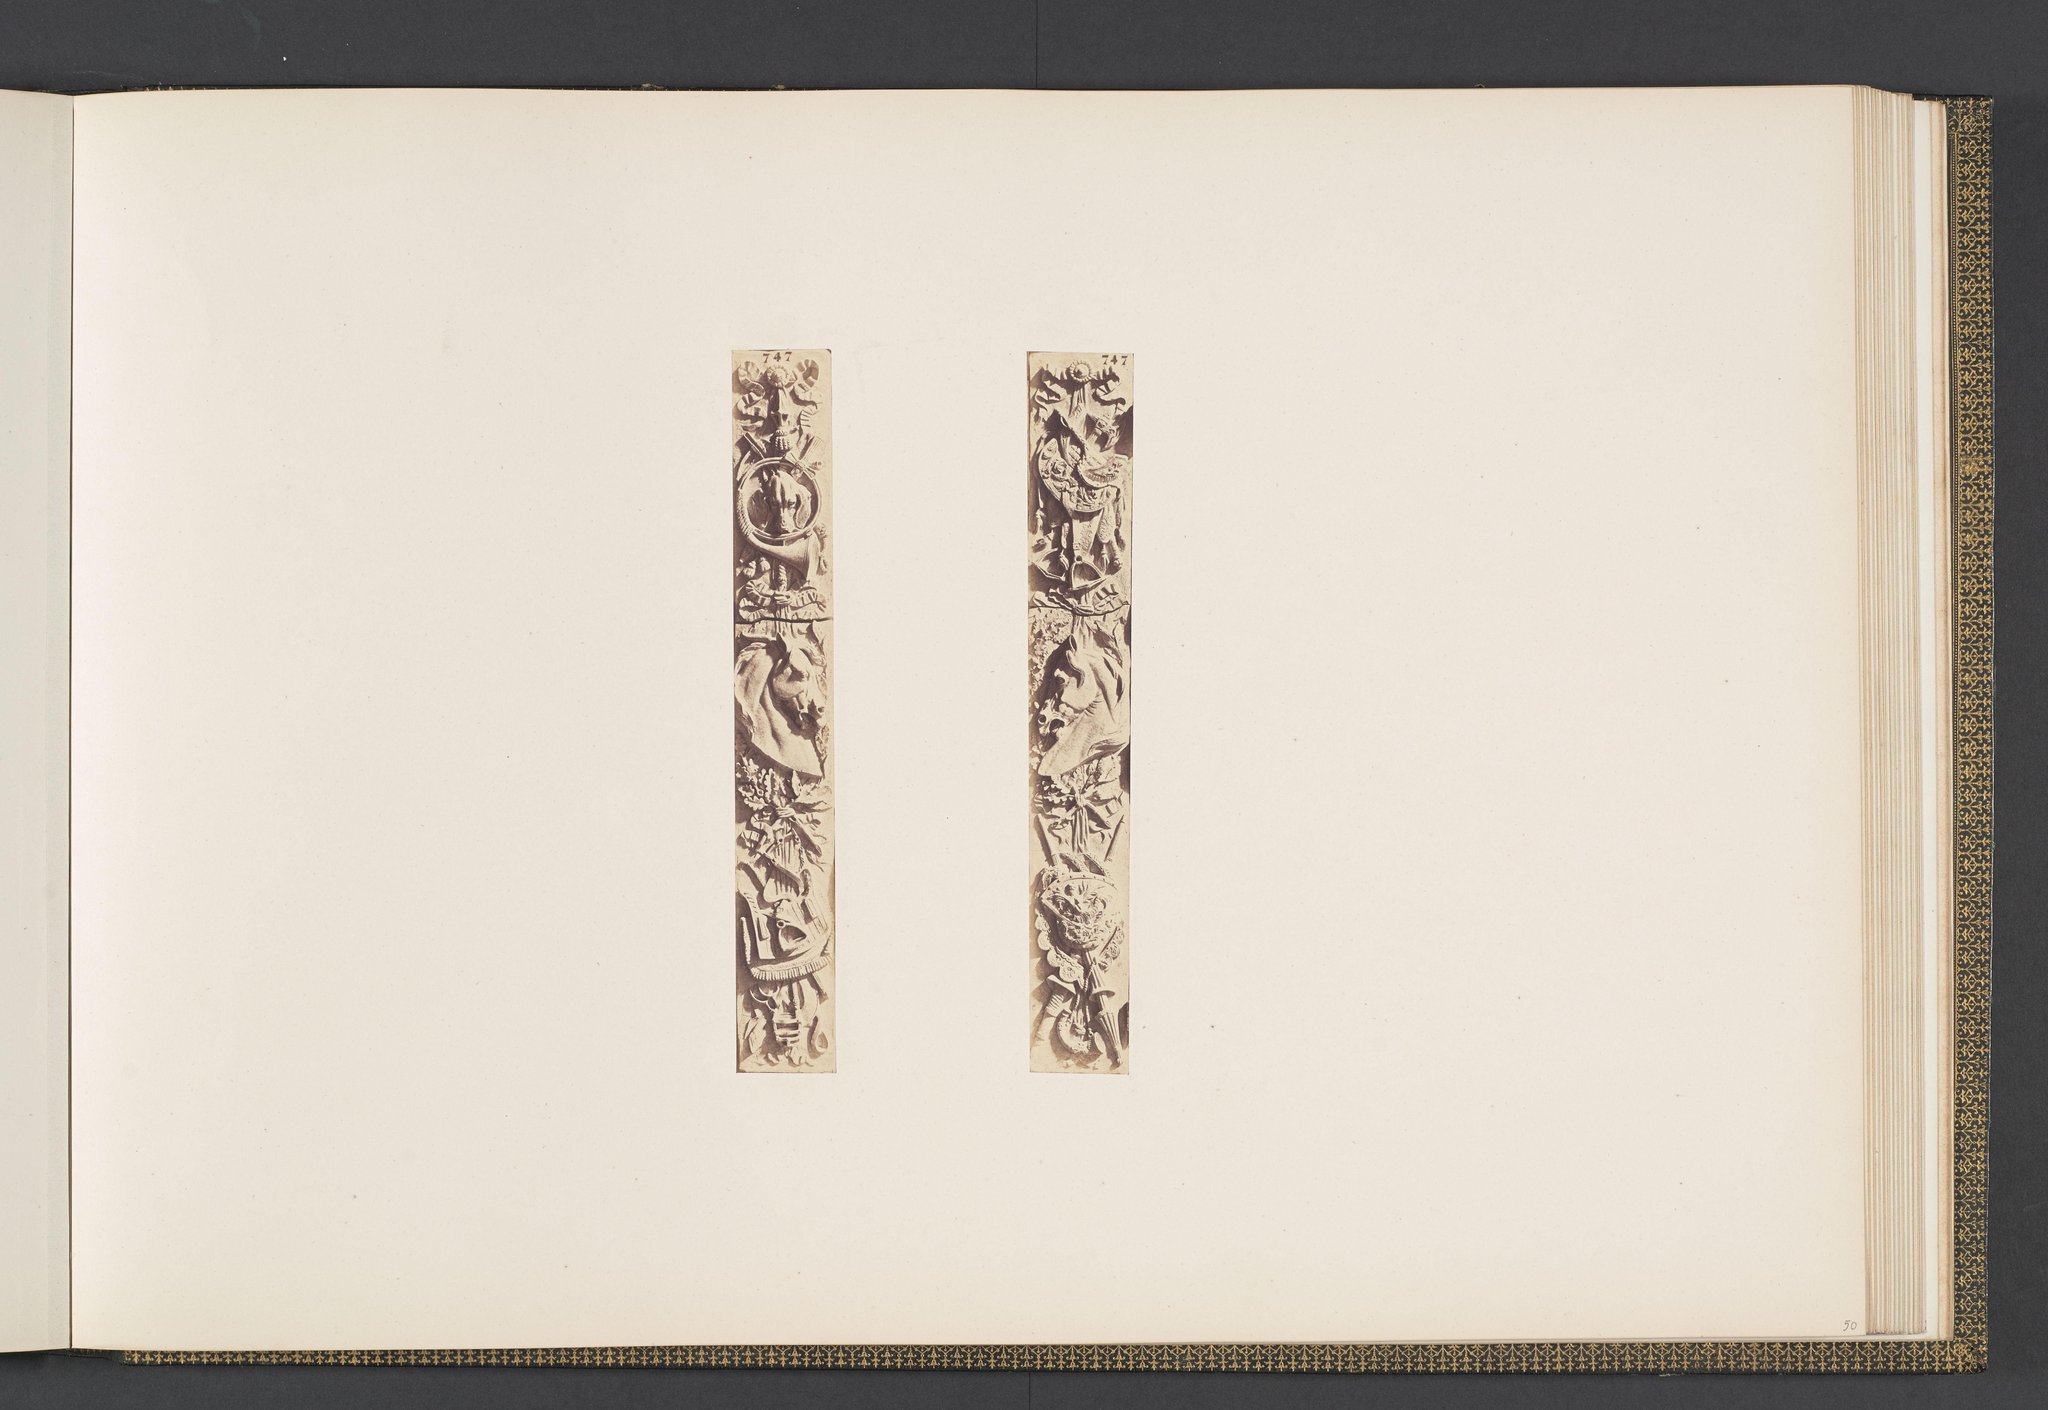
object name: photograph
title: Gipsmodellen voor gevelversieringen aan de Cour Visconti van het Palais du Louvre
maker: édouard denis baldus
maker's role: fotograaf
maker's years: 1813-1889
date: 1855-1857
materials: paper, photographic support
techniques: salted paper print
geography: paris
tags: permanent exhibition, museum, ornamenting, decorating ~ applied arts, paris, tuileries palace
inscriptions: number: ‘747 (beide)’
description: Onderdeel van Réunion des Tuileries au Louvre 1852-1857, album 3.